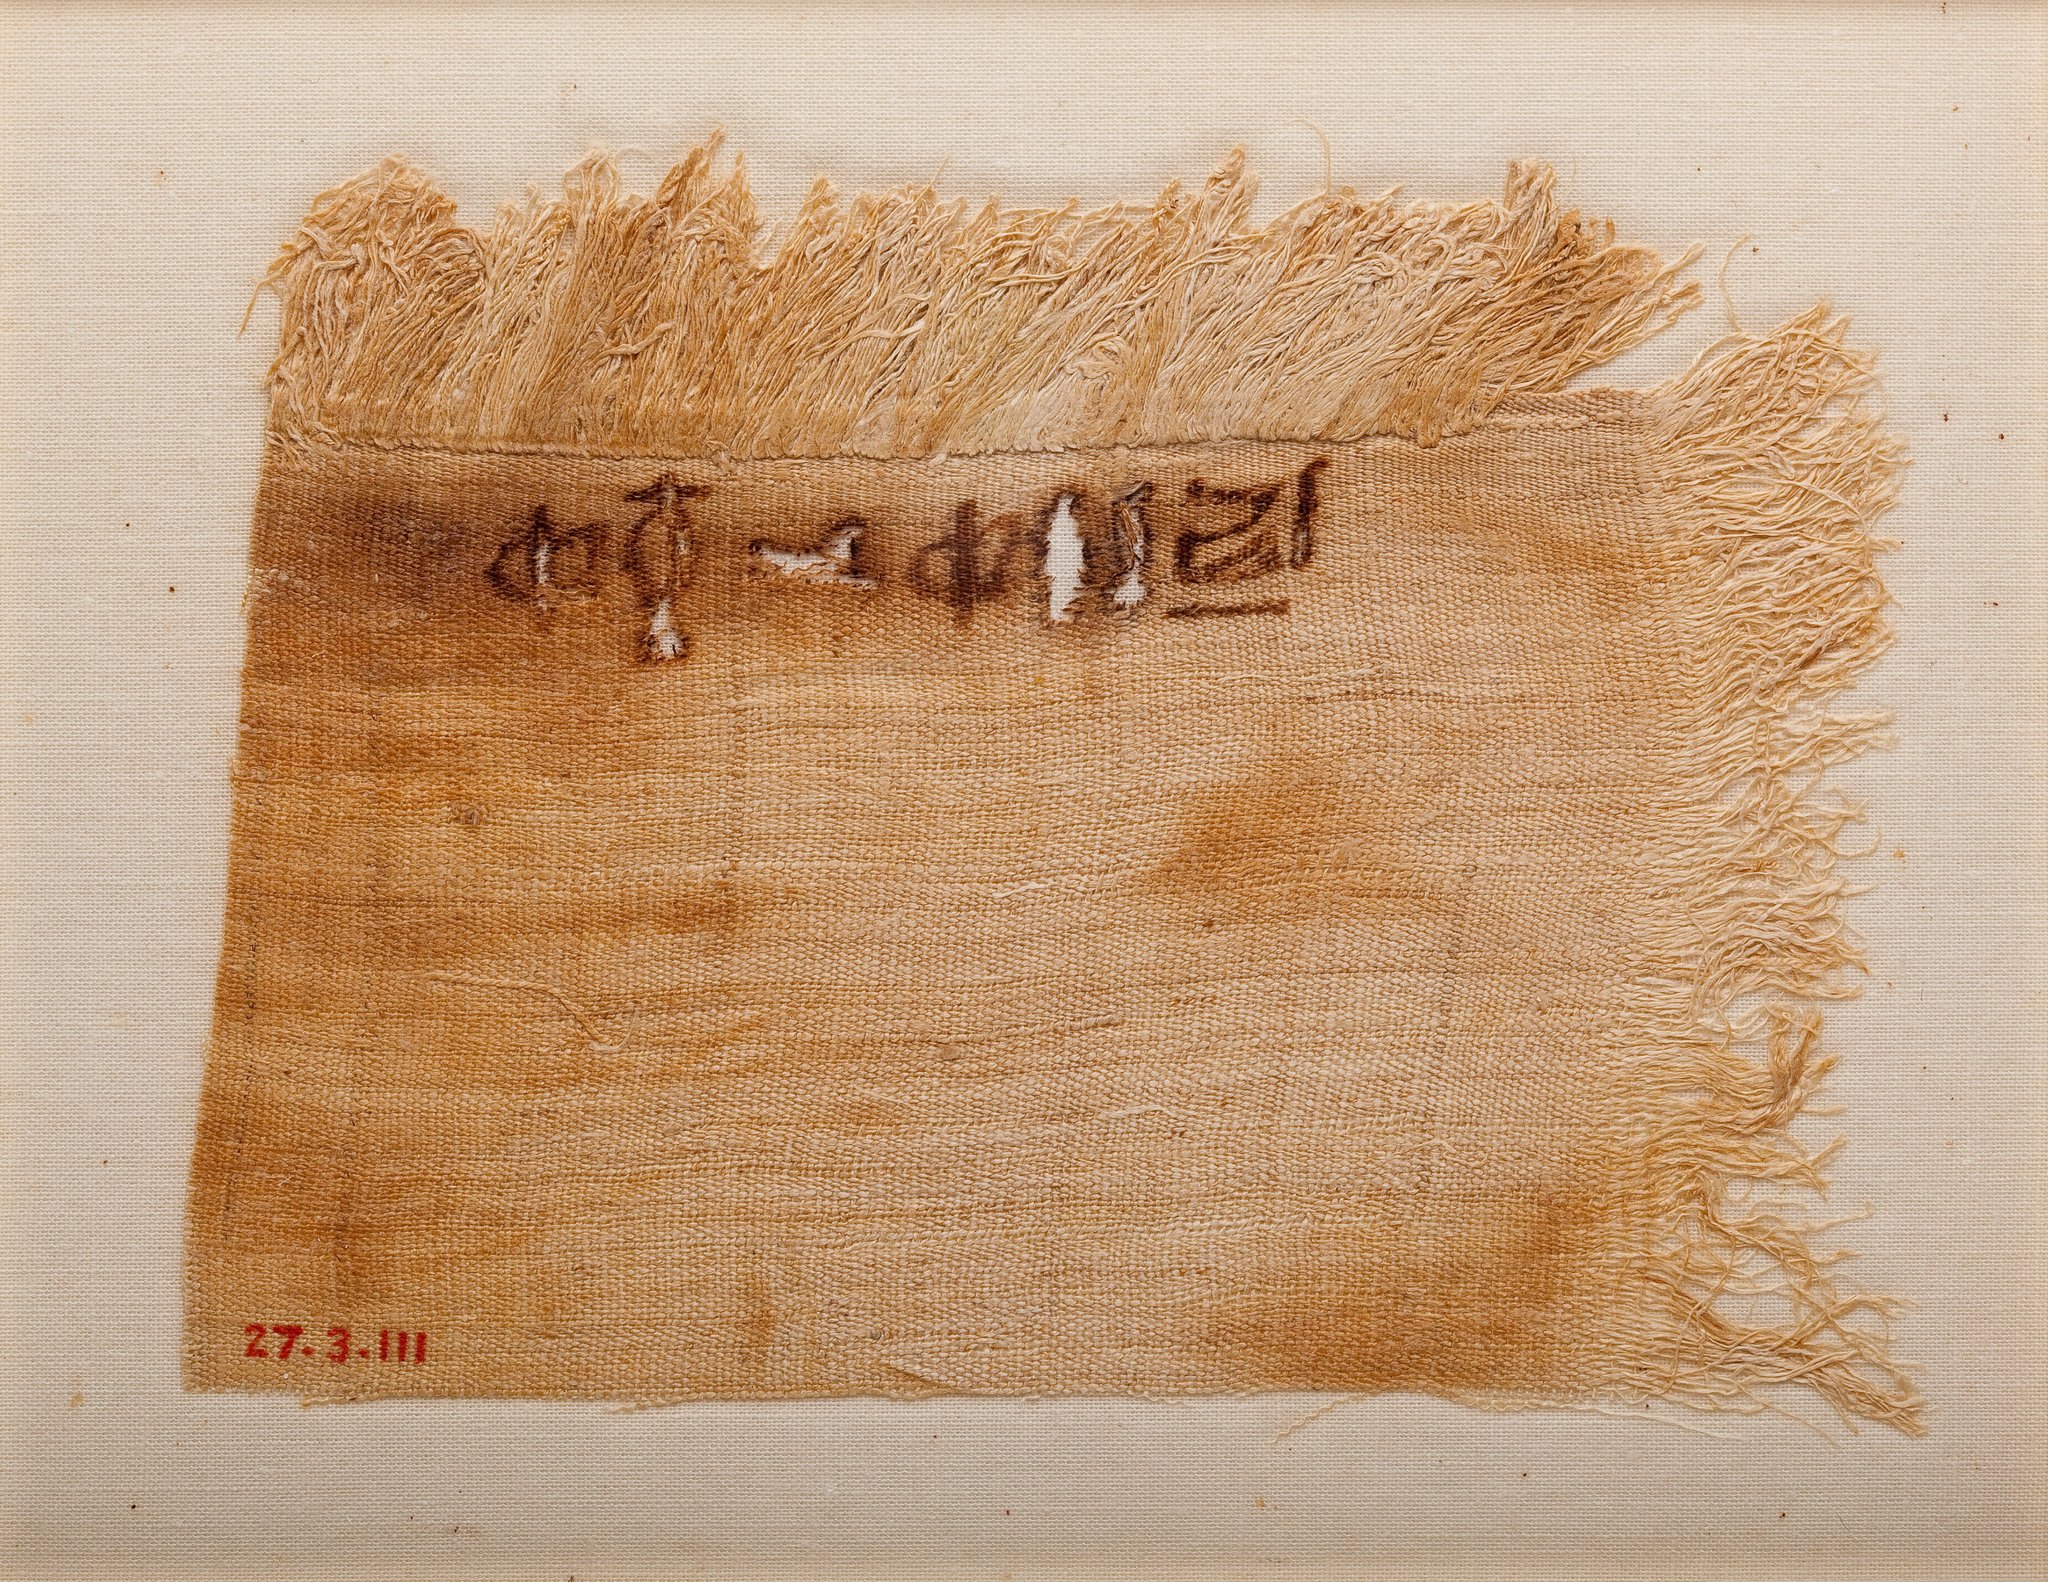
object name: linen mark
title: Linen mark (Type XIII)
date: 1961-1917 BCE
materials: linen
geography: egypt